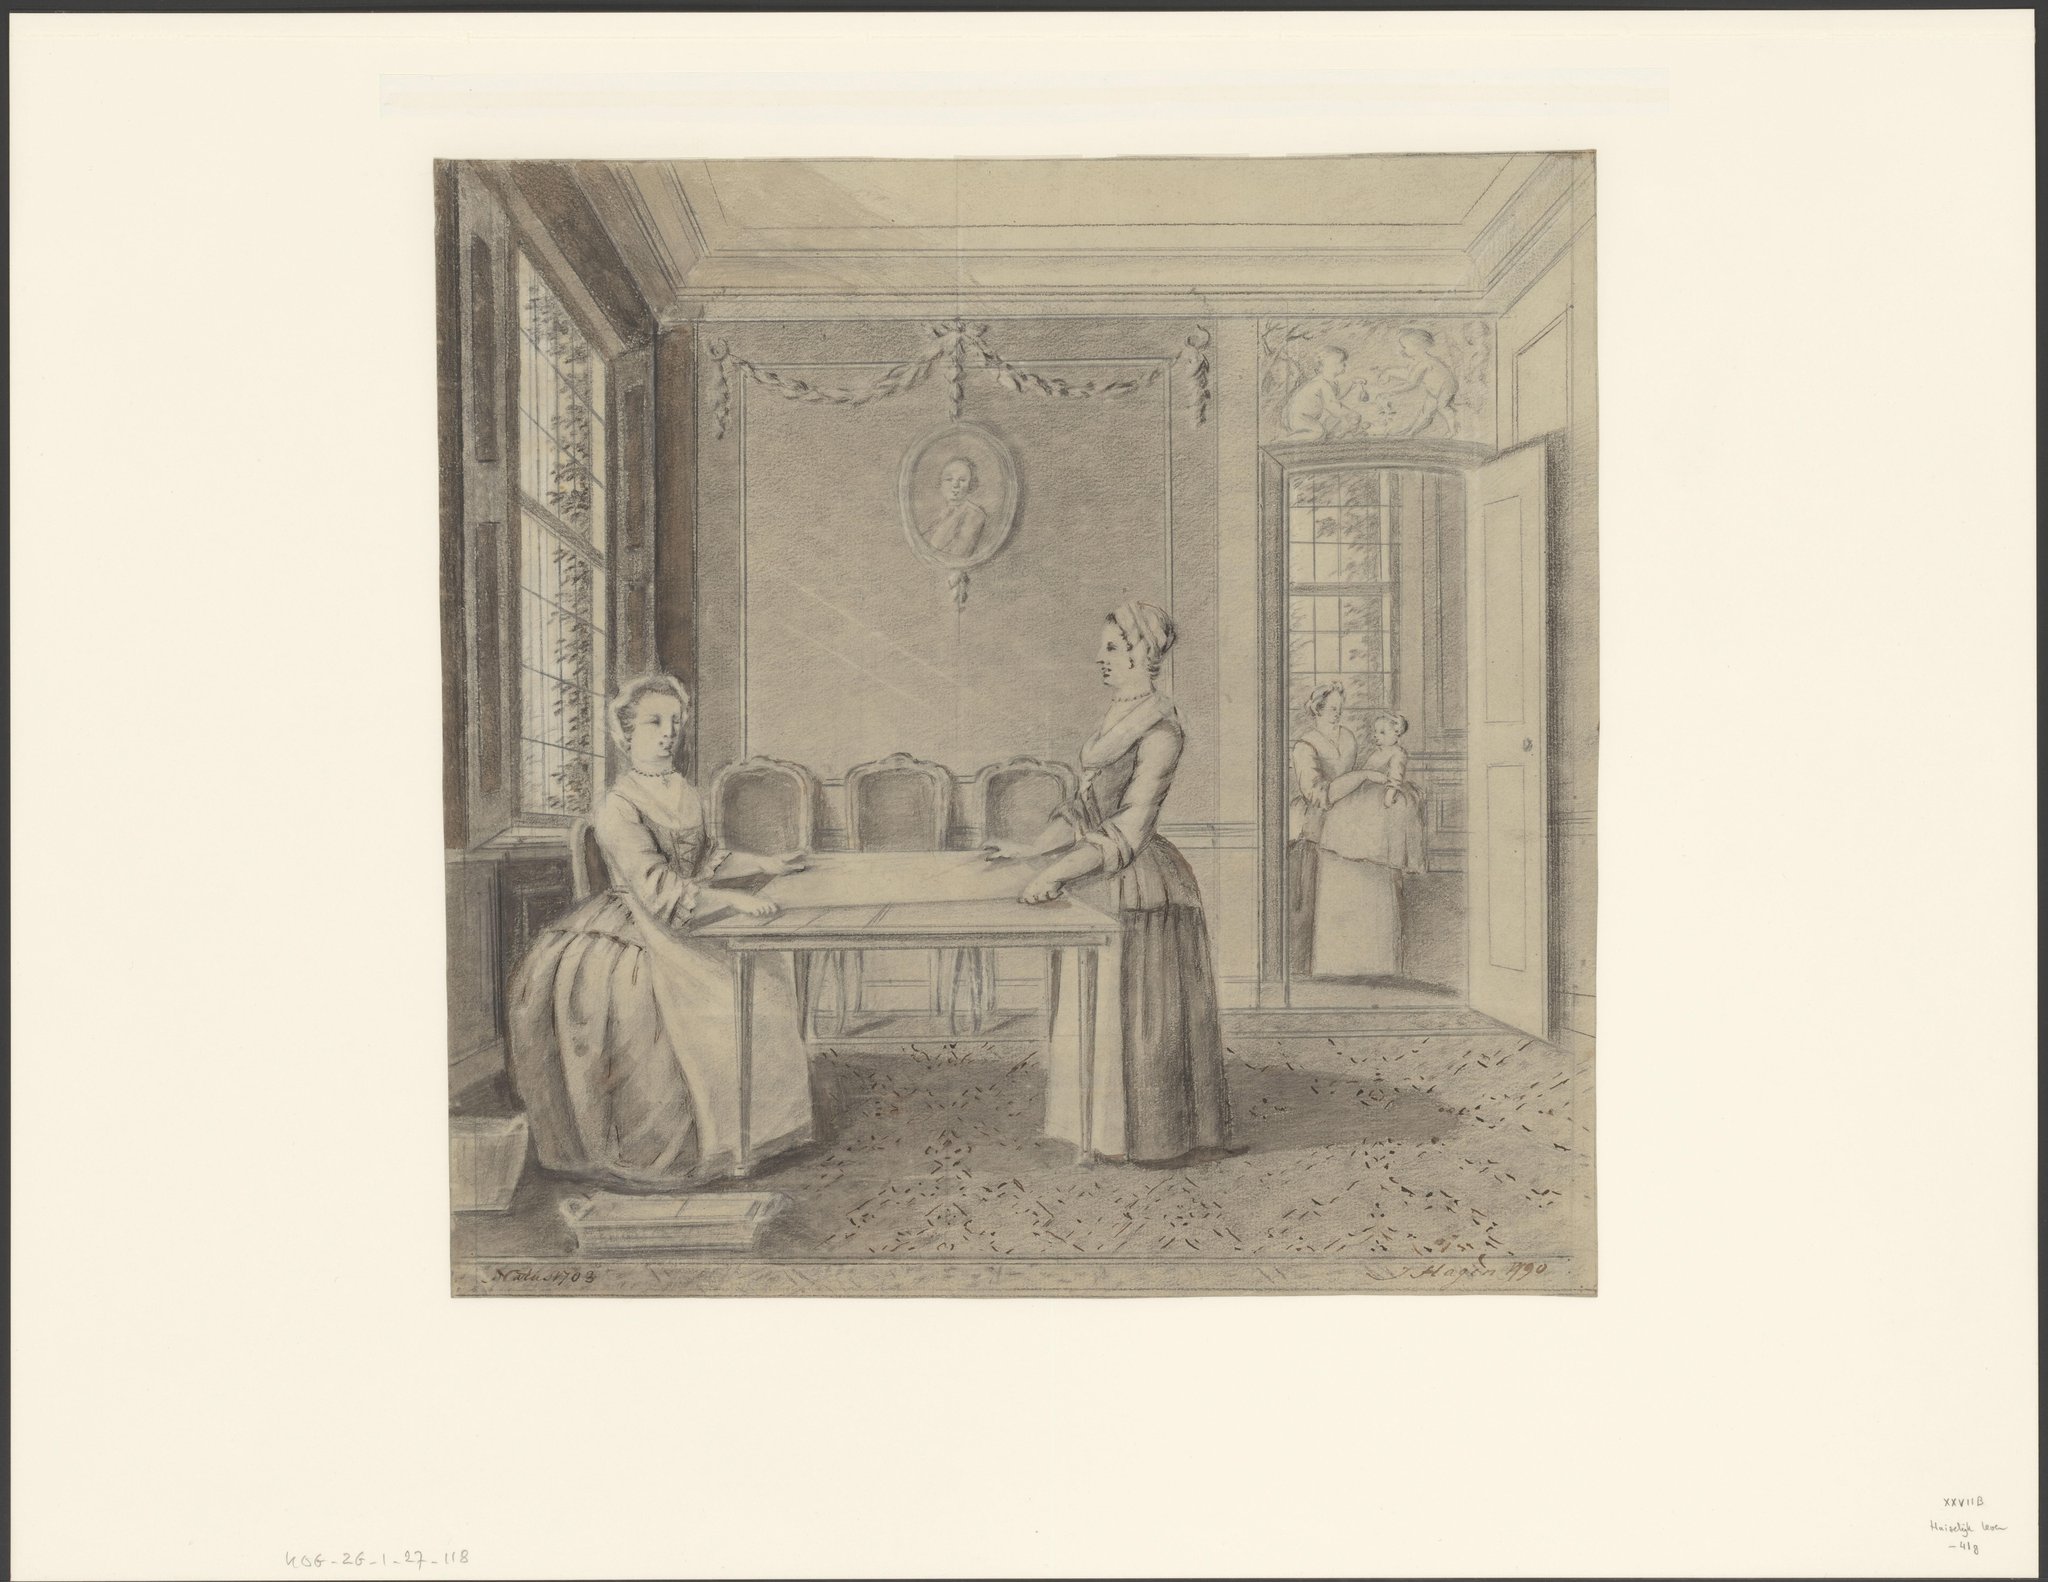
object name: drawing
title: Huiselijke taferelen door Jacob Hagen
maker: jacob hagen (ii)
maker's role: draughtsman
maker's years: 1703-1791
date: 1790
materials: chalk, ink, paper, pencil, watercolor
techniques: brush, pen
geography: netherlands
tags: laundering, communal rooms, family life at home